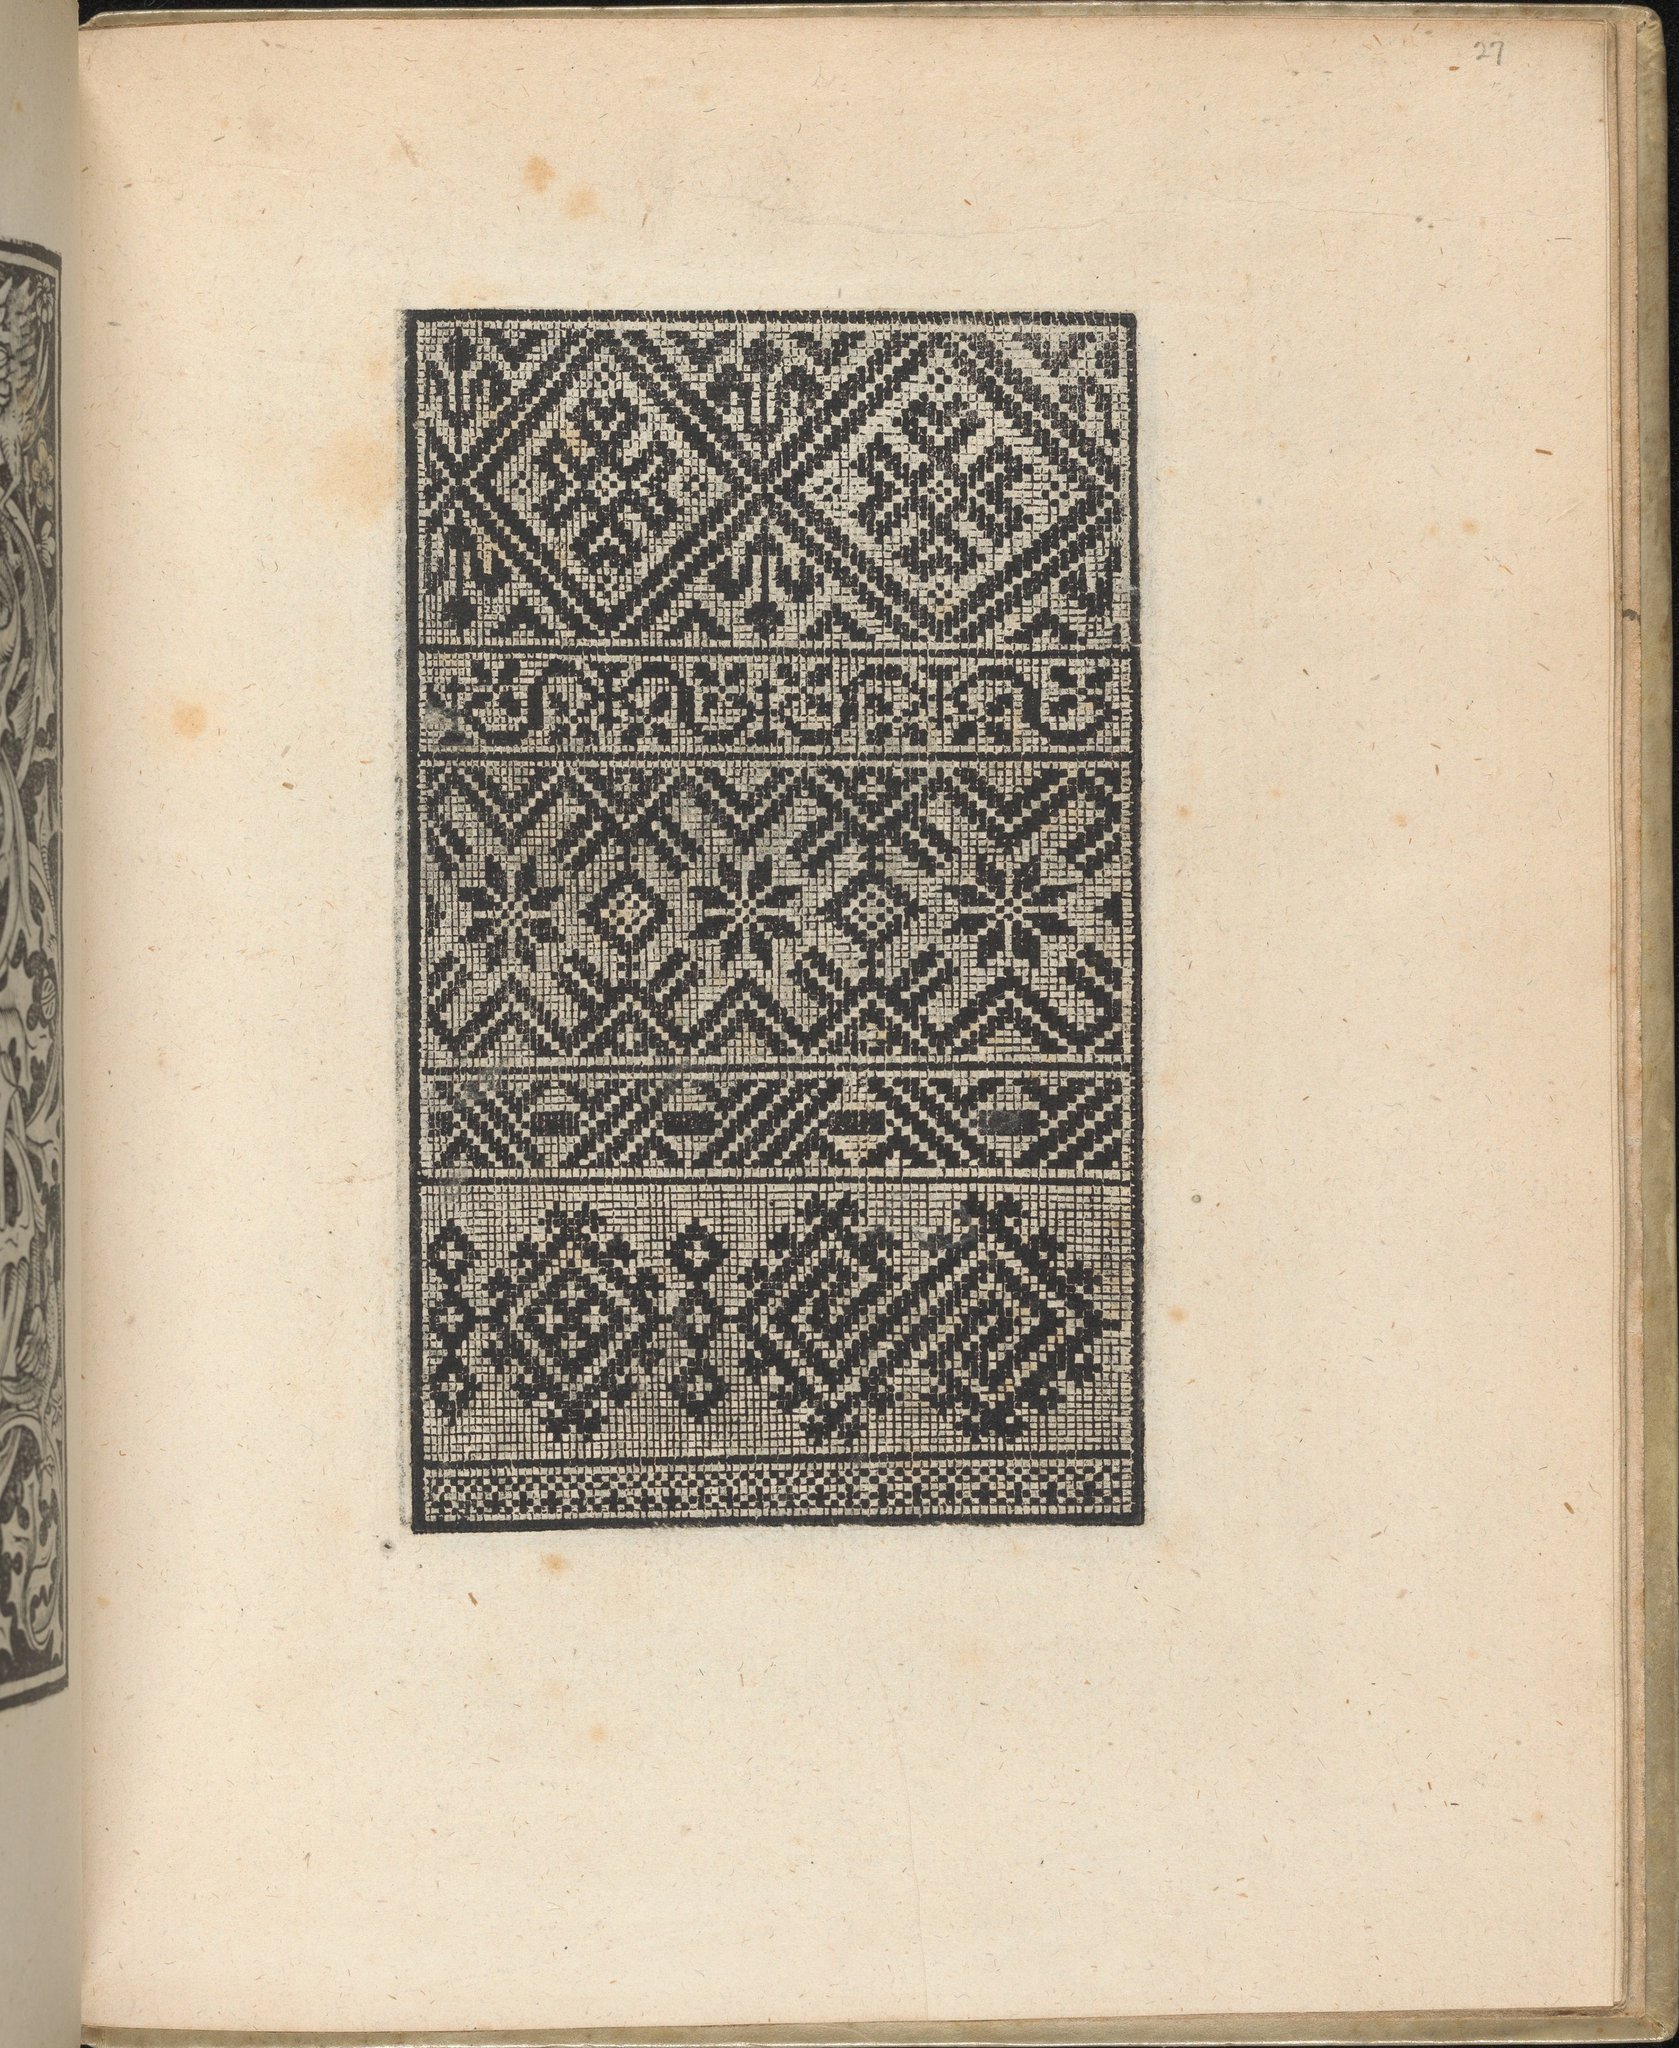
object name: book print ornament architecture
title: Trionfo Di Virtu. Libro Novo..., page 27 (verso)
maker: matteo pagano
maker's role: publisher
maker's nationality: italian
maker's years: 1515-1588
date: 1563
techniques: woodcut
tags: flowers